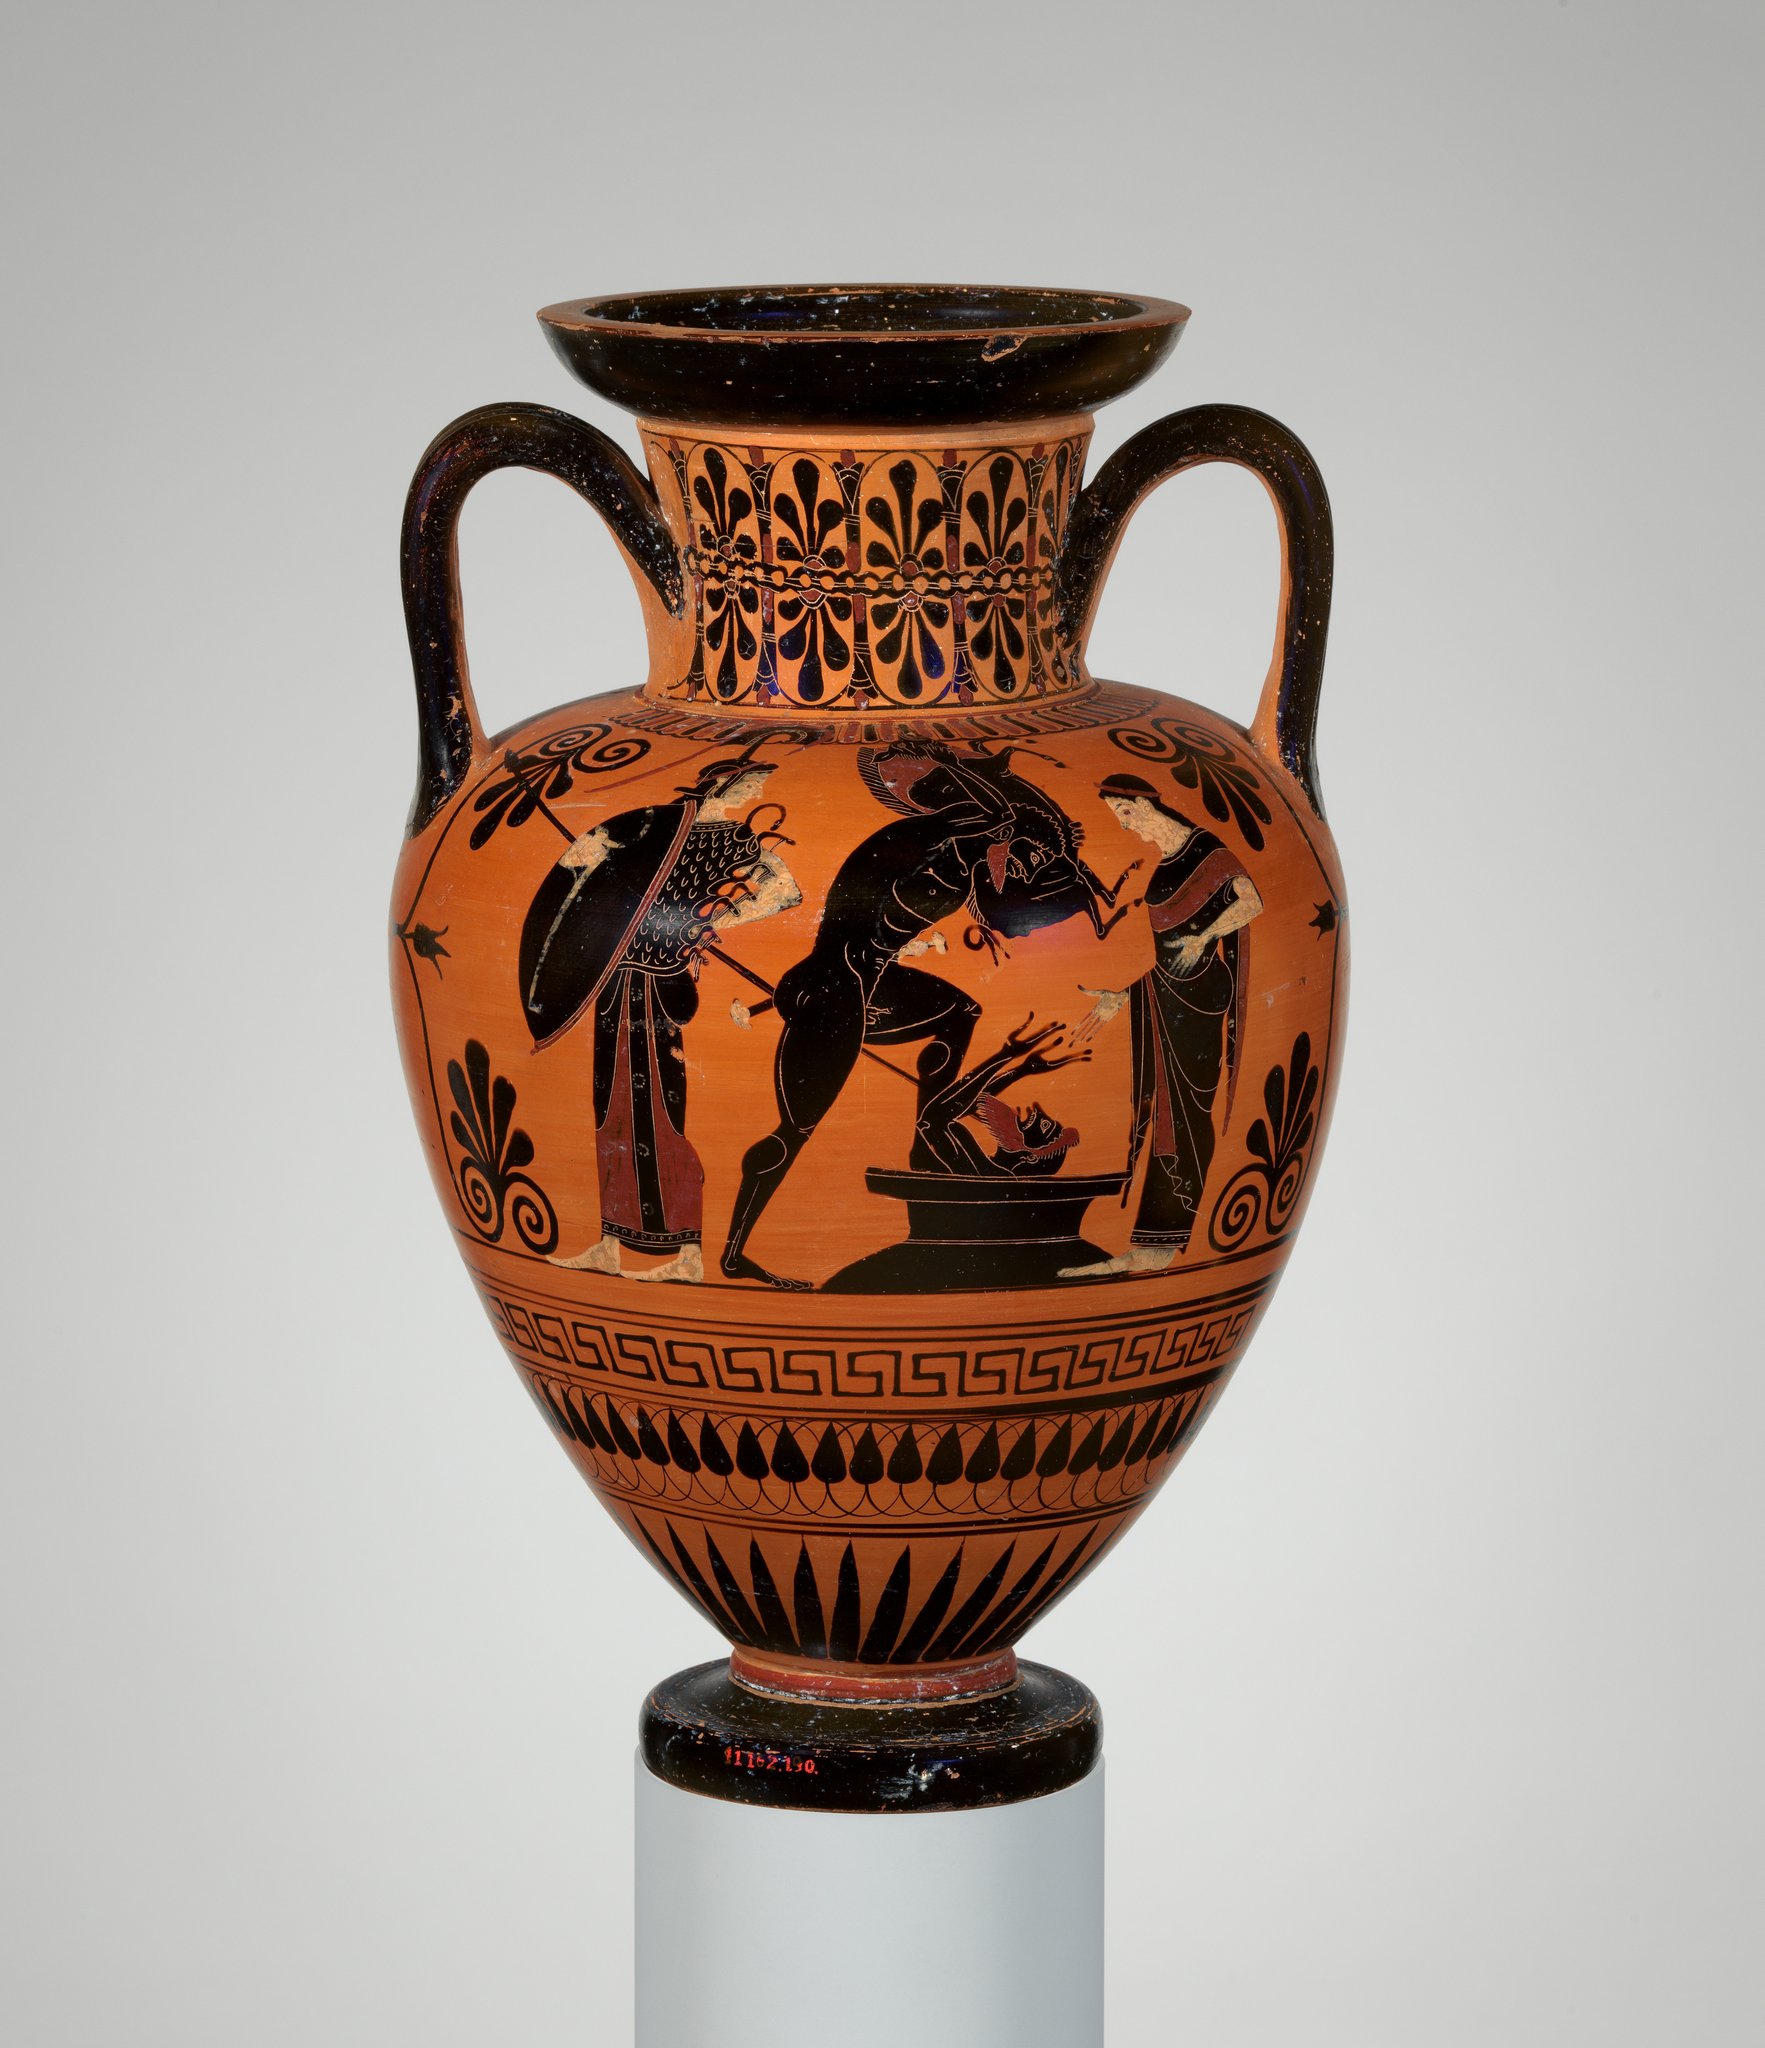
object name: neck amphora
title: Neck-amphora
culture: greek, attic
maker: group of würzburg 199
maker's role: artist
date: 525-501 BCE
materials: terracotta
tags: women,boars,herakles